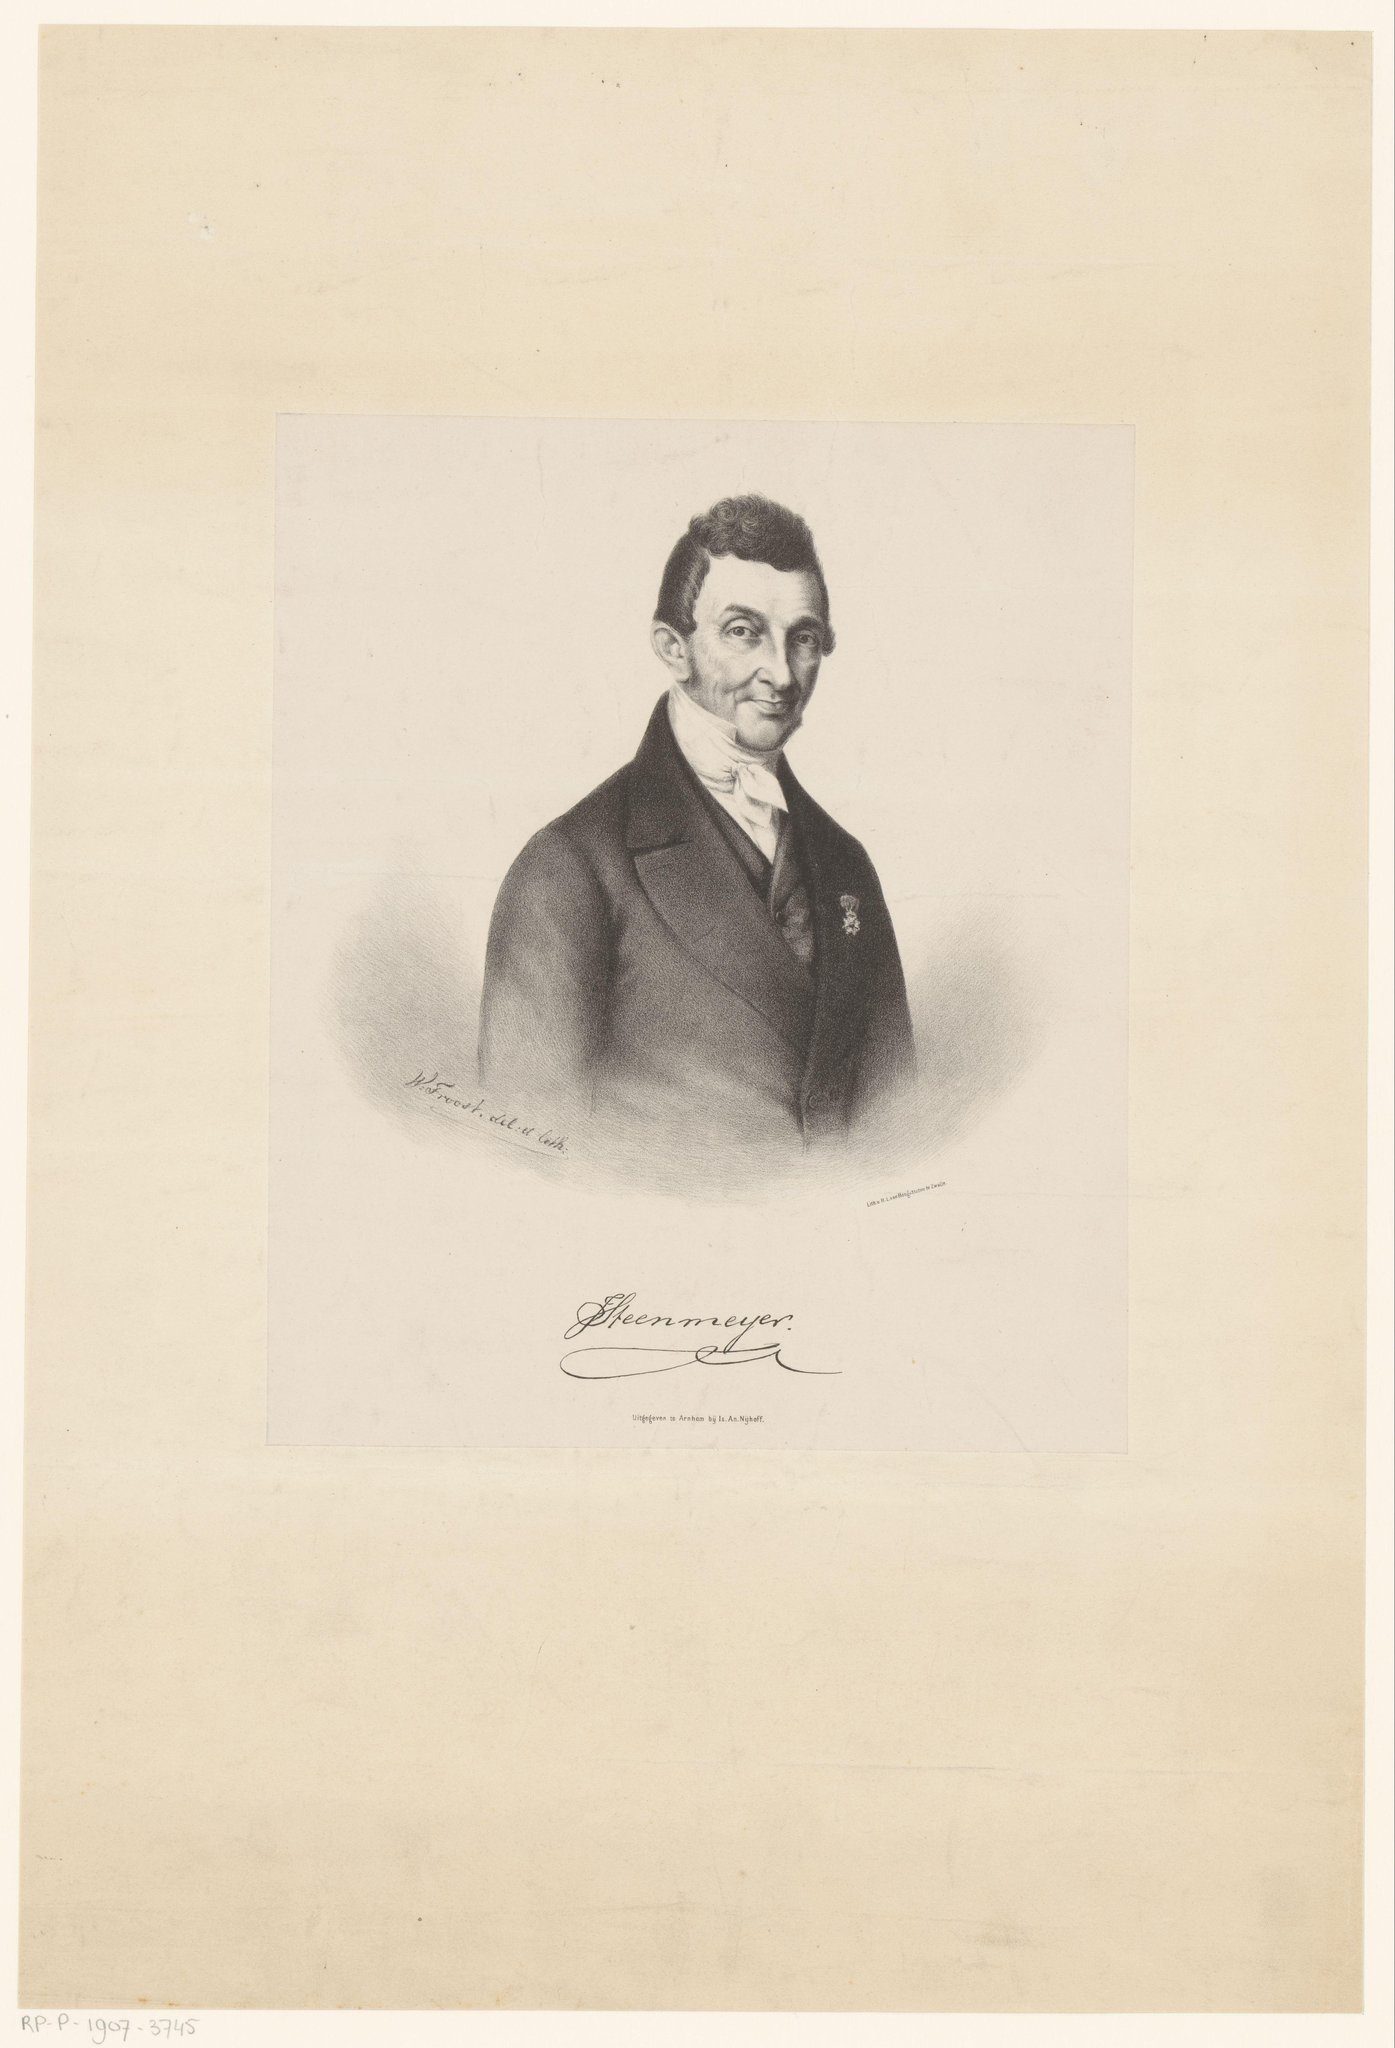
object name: print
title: Portret van Johannes Steenmeijer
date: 1854-1859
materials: paper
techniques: lithograph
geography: arnhem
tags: amsterdam, arnhem, historical persons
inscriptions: collector's mark: Lugt 2228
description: Onder het portret de signatuur van de geportretteerde.